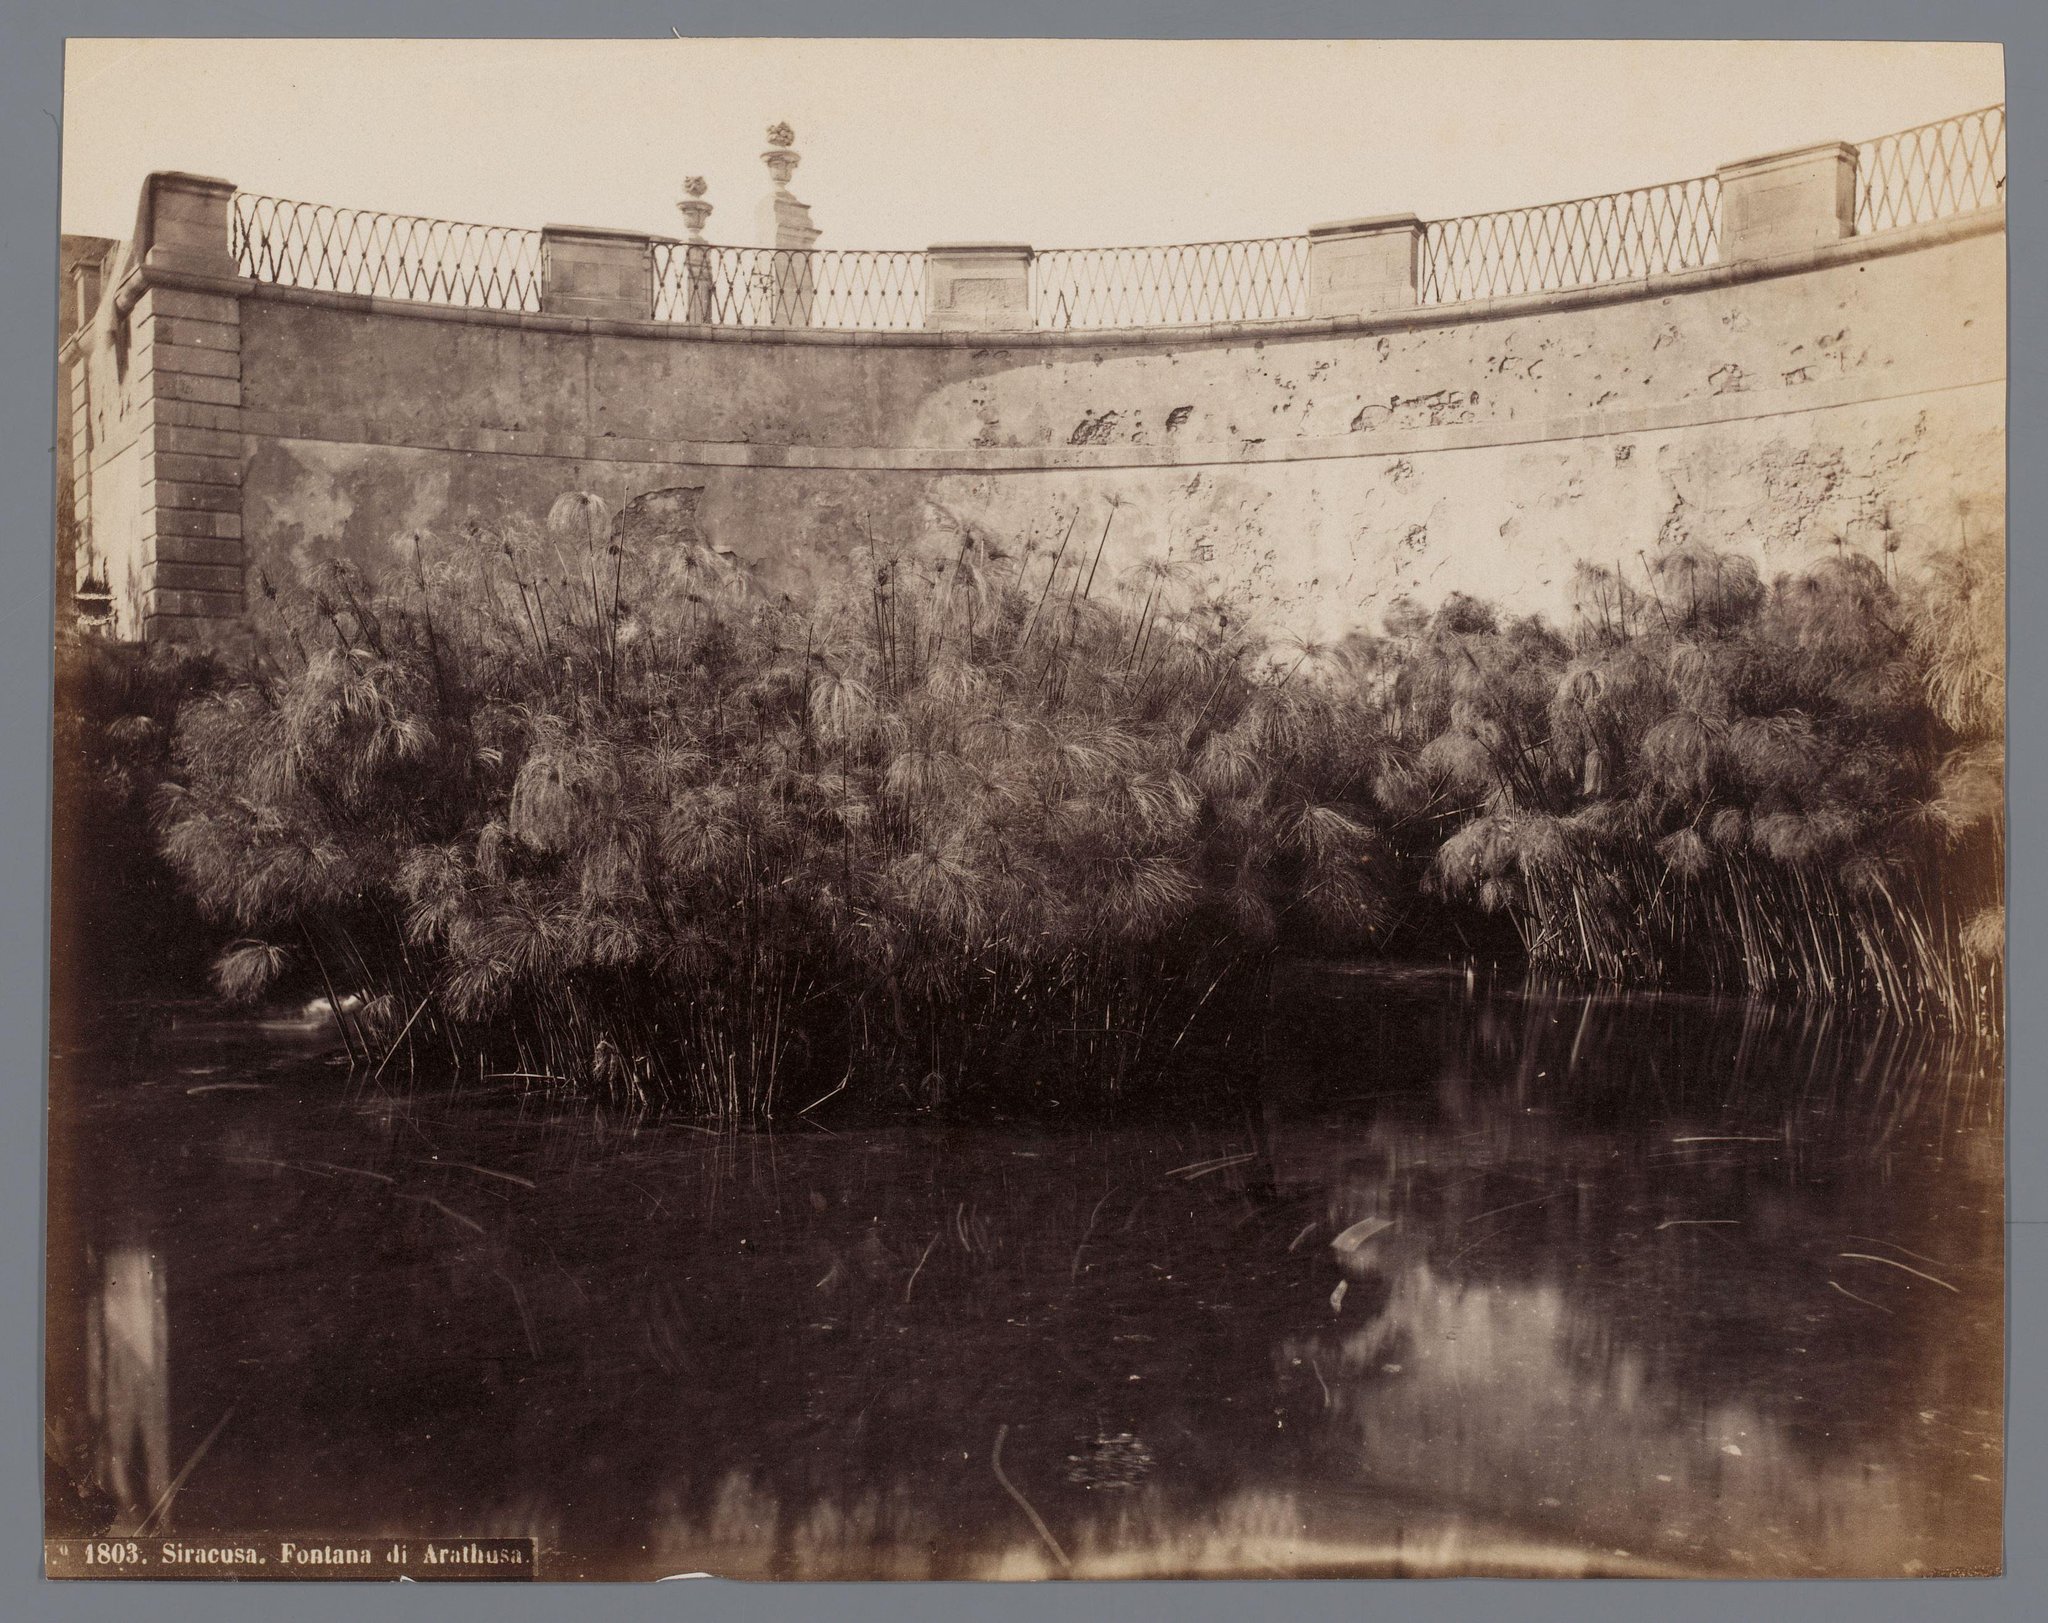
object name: photograph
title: Fontein van Arethusa, Syracuse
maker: roberto rive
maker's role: fotograaf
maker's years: 1825-1868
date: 1860-1889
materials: paper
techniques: albumen print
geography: syracuse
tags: well, balustrade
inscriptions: inscription: ‘1870's/ 25,=’, number: ‘No. 1803’, number: ‘1179’